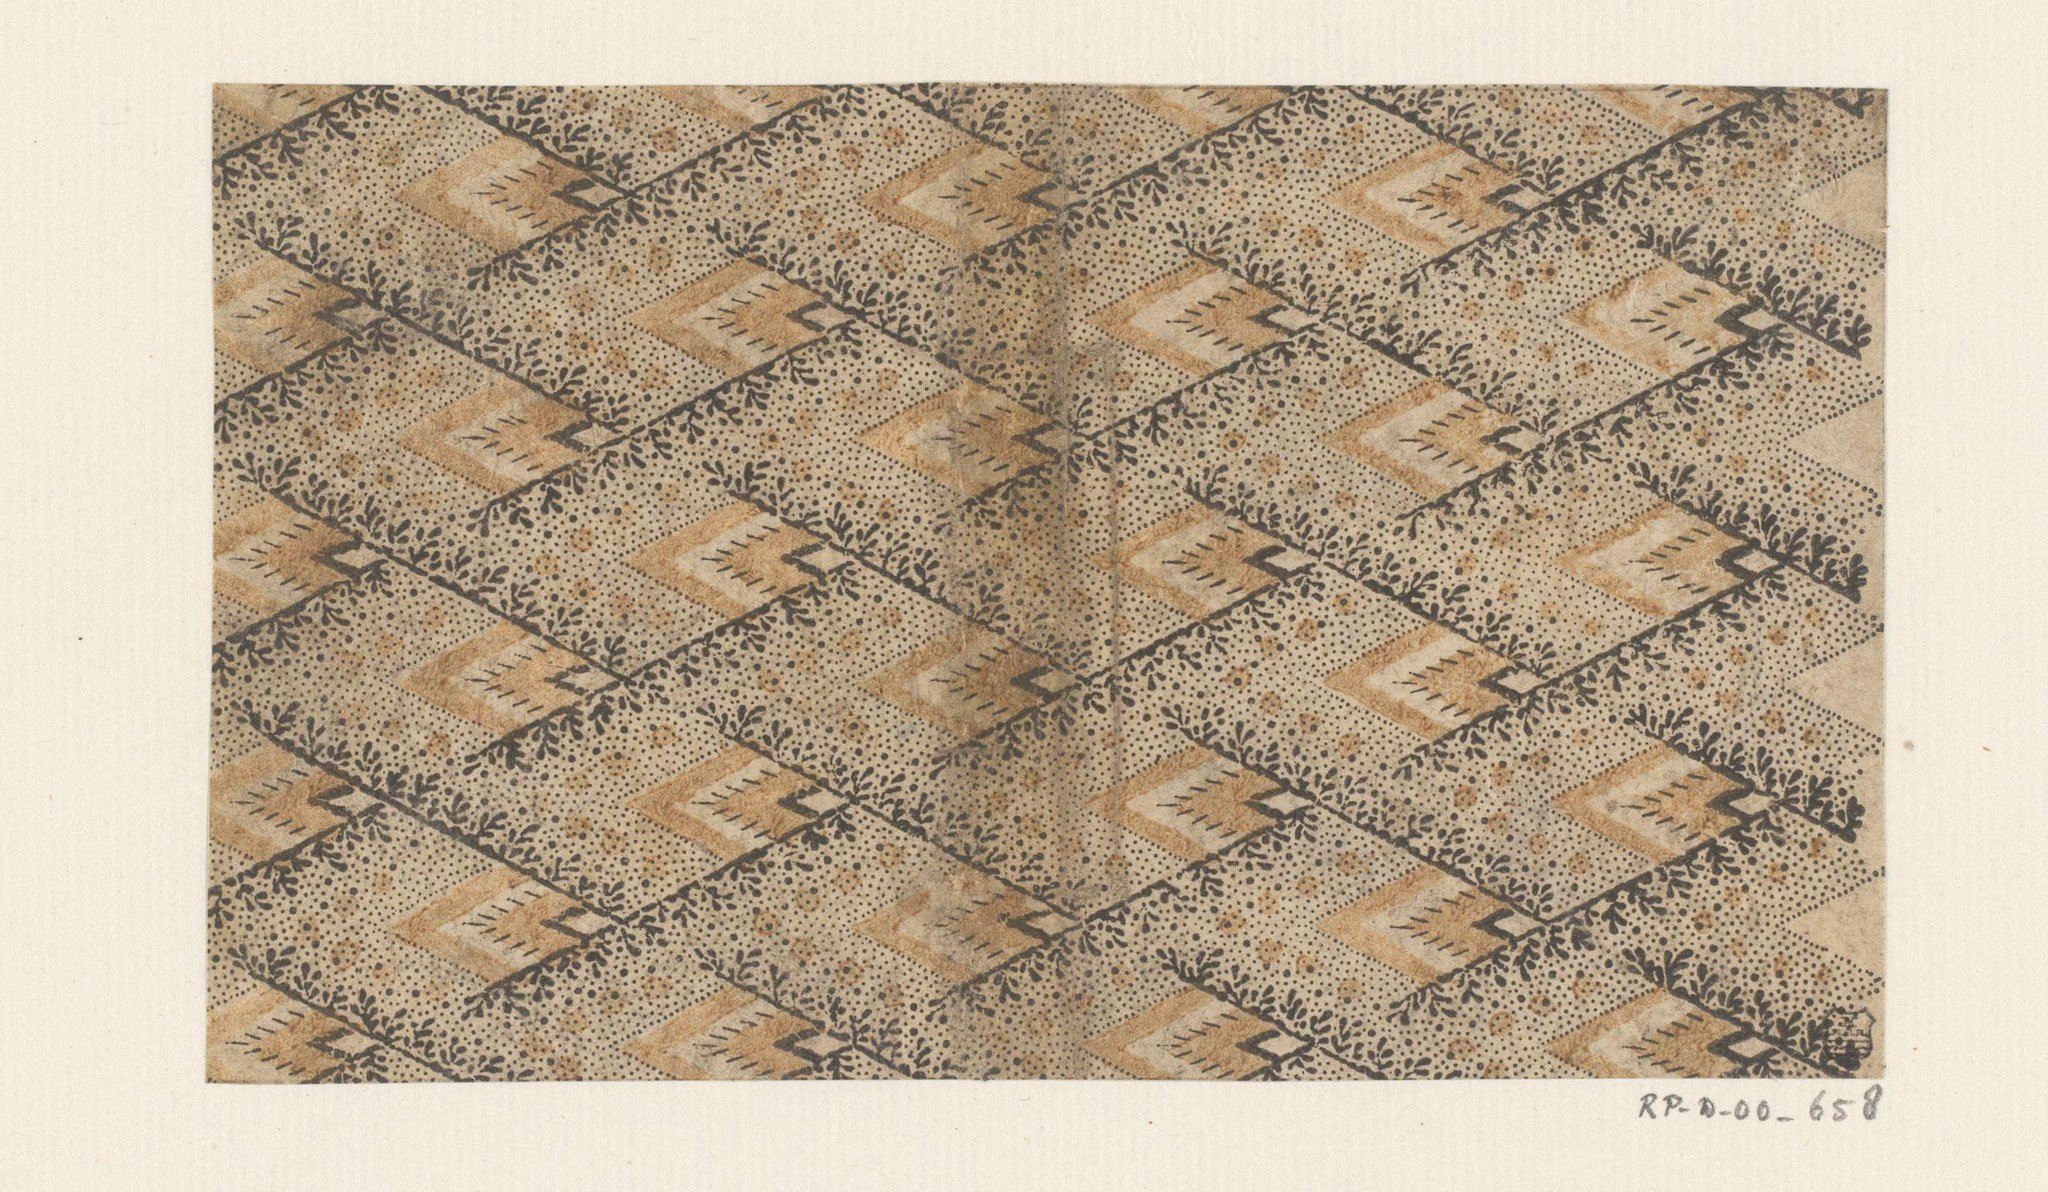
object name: printed paper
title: Blad met ruitenpatroon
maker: Anonymous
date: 1750-1900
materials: paper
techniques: printing block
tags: ornament ~ geometric motifs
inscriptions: collector's mark: Lugt 2760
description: Blad met ruitenpatroon van overlappende diagonale banen. Gebruikt als omslag.